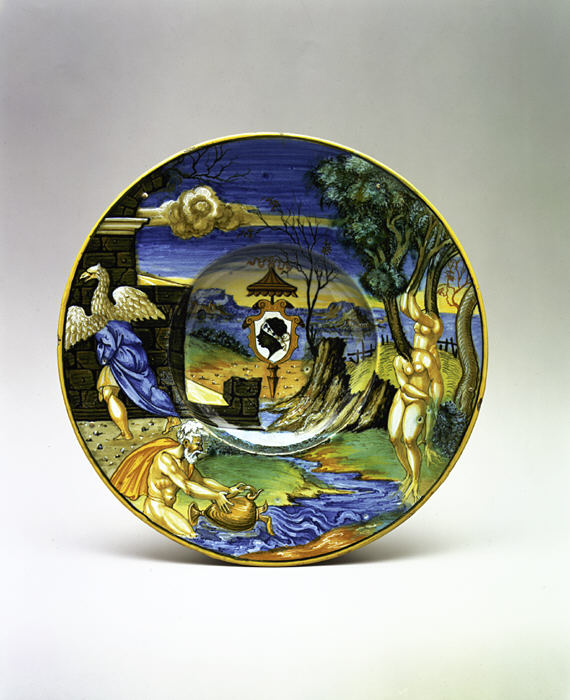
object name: dish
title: Armorial dish: The story of Phaeton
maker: francesco xanto avelli da rovigo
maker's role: artist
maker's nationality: italian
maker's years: 1482-1542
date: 1532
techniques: maiolica, glazing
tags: men,swans,trees